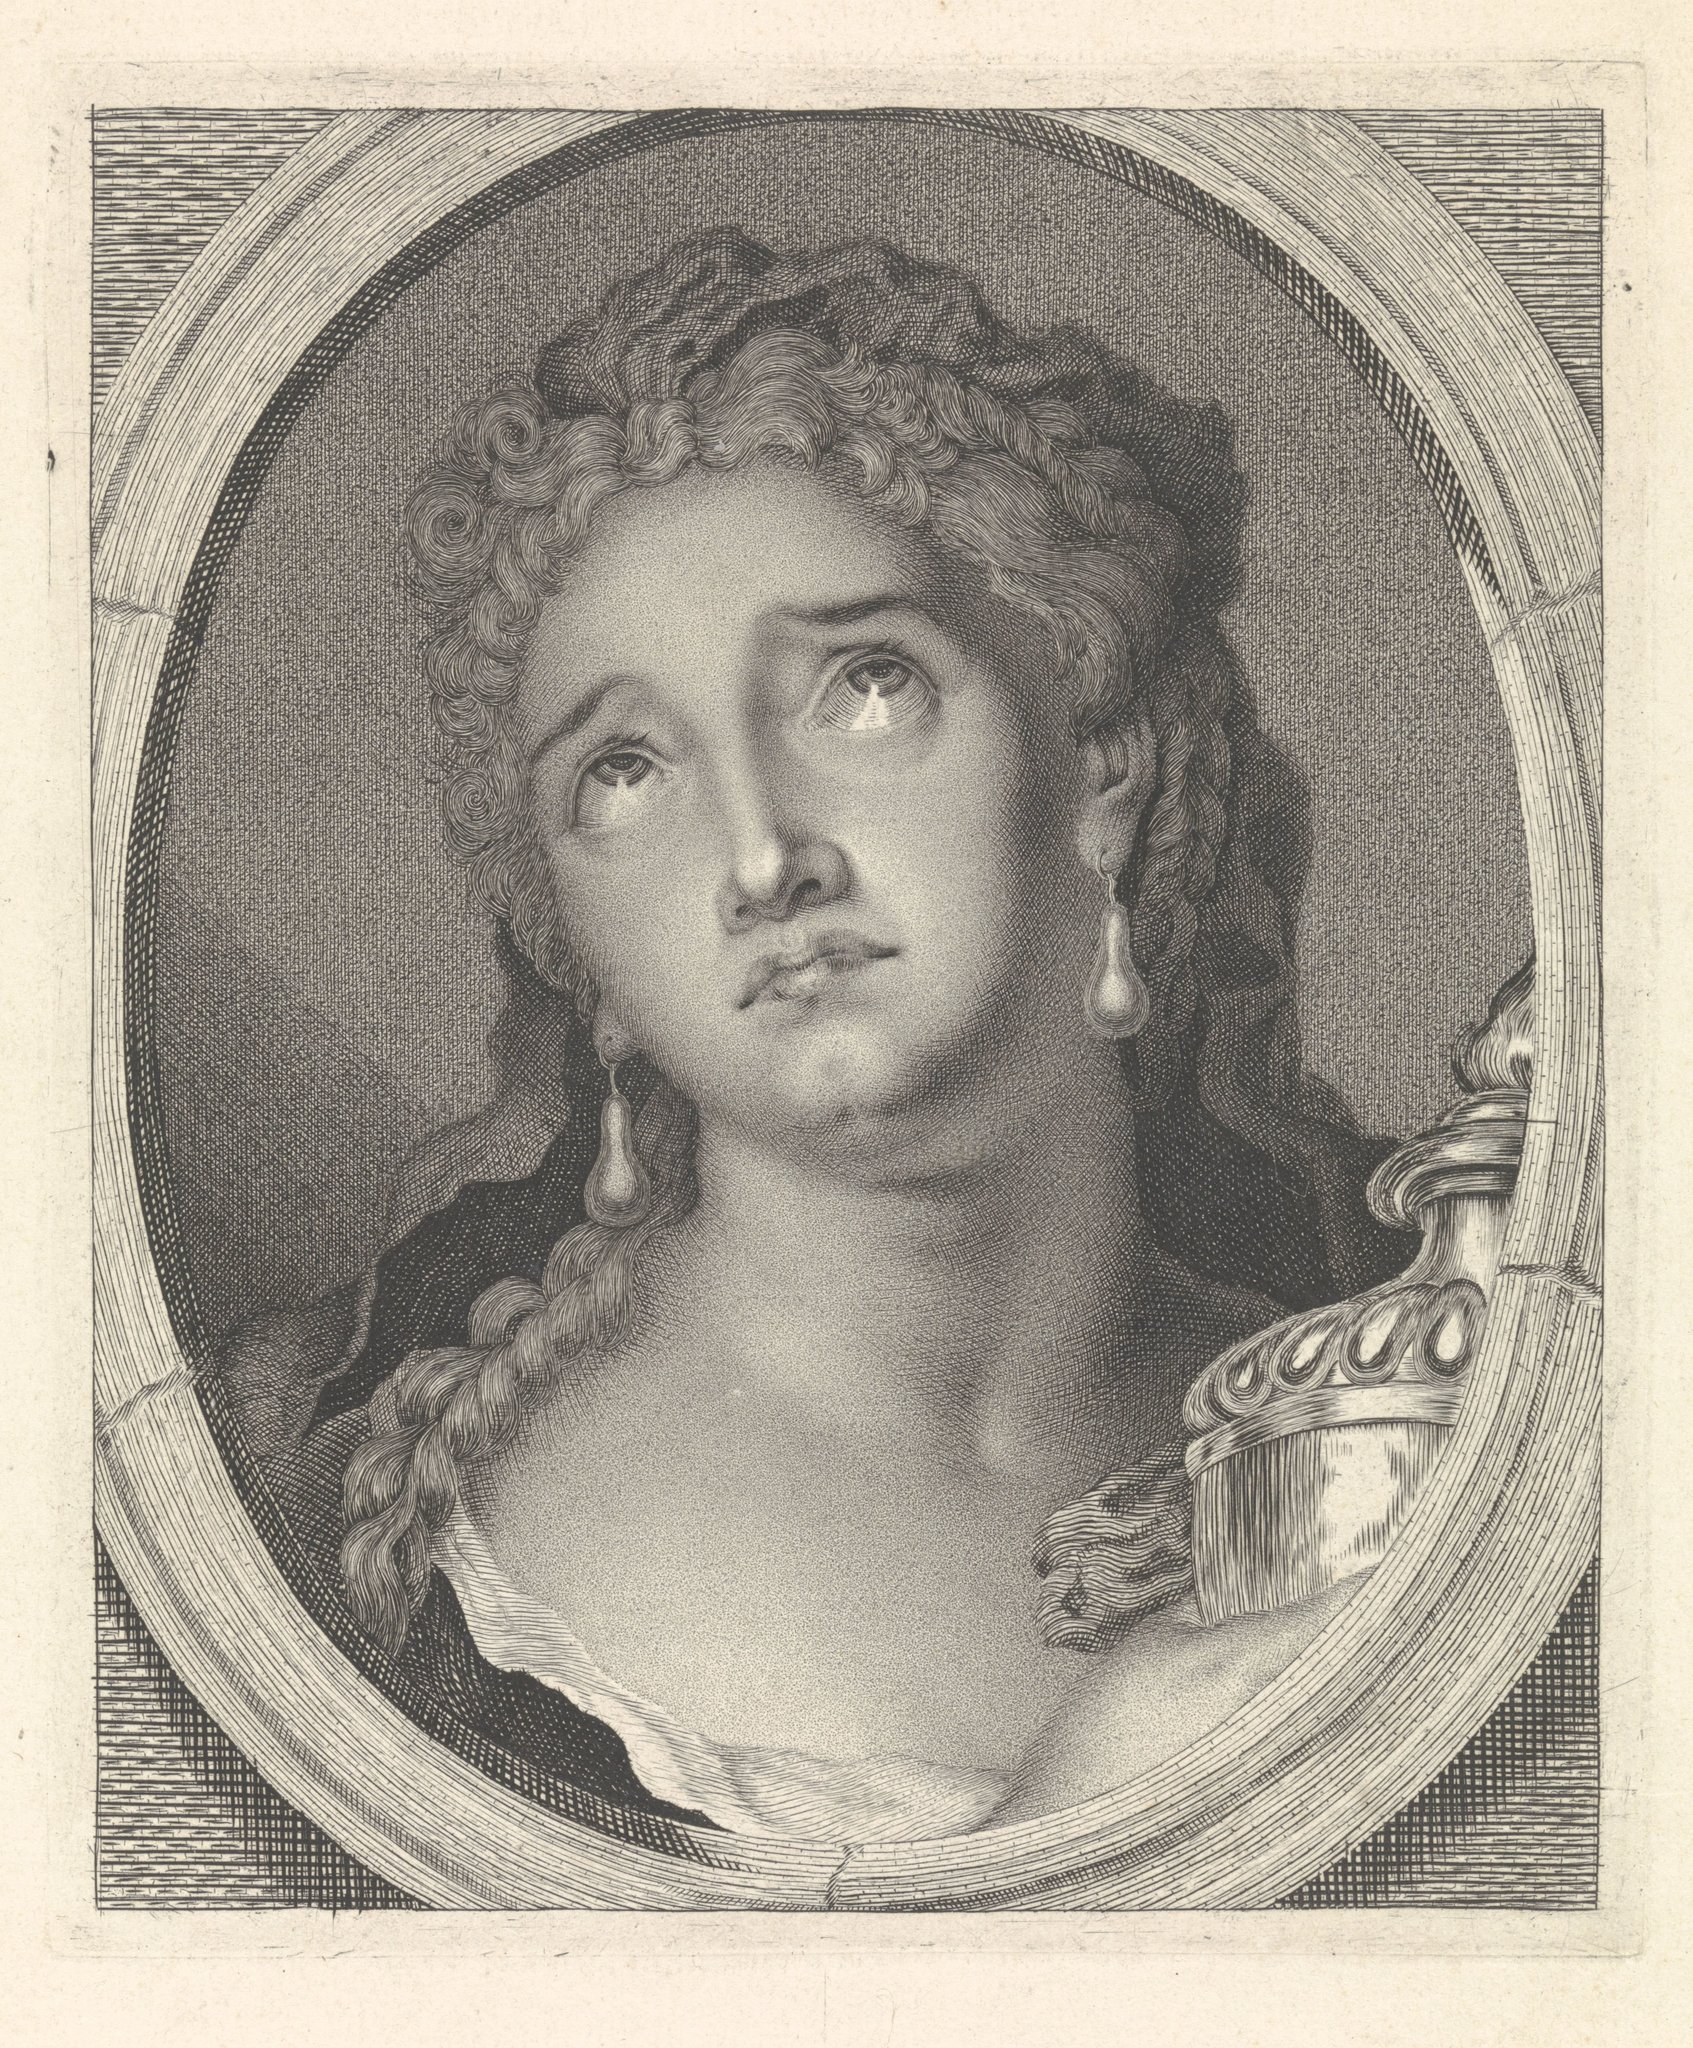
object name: print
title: Adrienne Lecouvret in de rol van Cornelia met een urn met de as van haar man Pompeus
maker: pieter lyonet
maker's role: draughtsman, print maker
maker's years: 1706-1789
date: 1716-1789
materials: paper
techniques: engraving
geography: france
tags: paris, historical persons - bb - woman, portrait of actor, actress, urn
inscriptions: collector's mark: Lugt 240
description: Actrice Adrienne Lecouvreur als Cornelia in Pierre Corneille's 'La mort de Pompée'. In haar handen een urn met de as van haar man Pompeus.